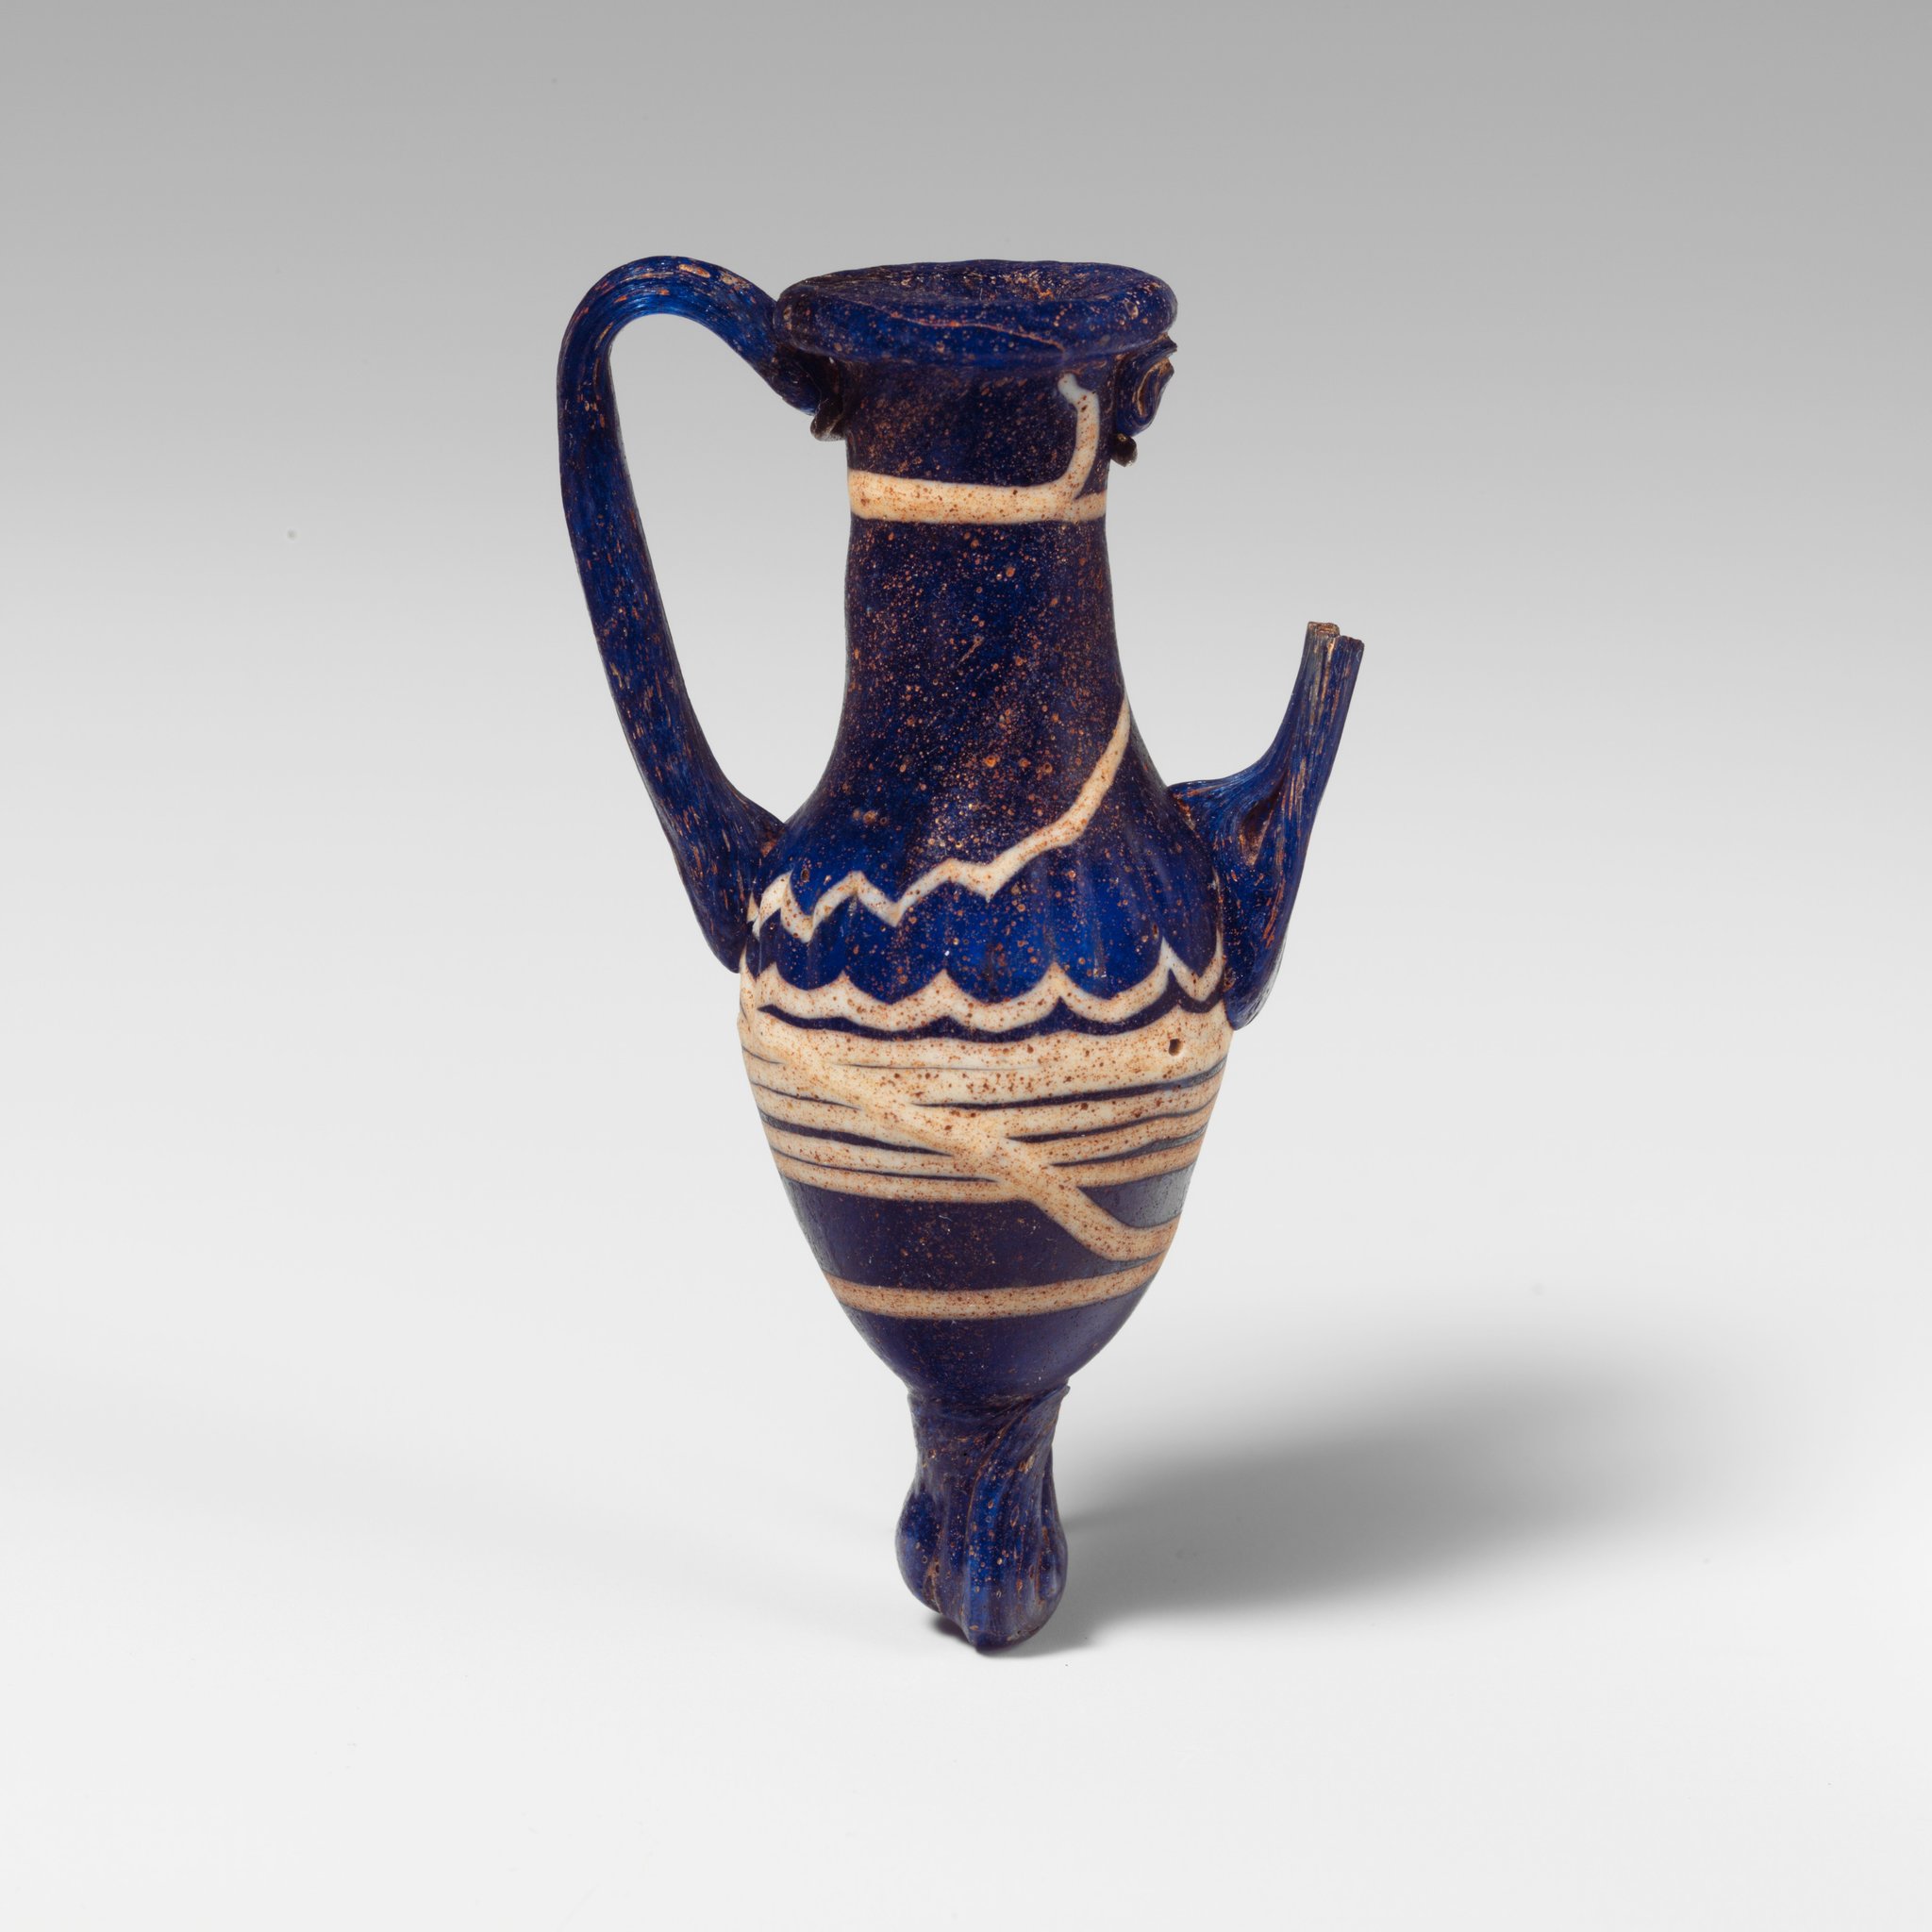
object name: amphoriskos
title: Glass amphoriskos (perfume bottle)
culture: greek or eastern mediterranean or italian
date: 300-201 BCE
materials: glass